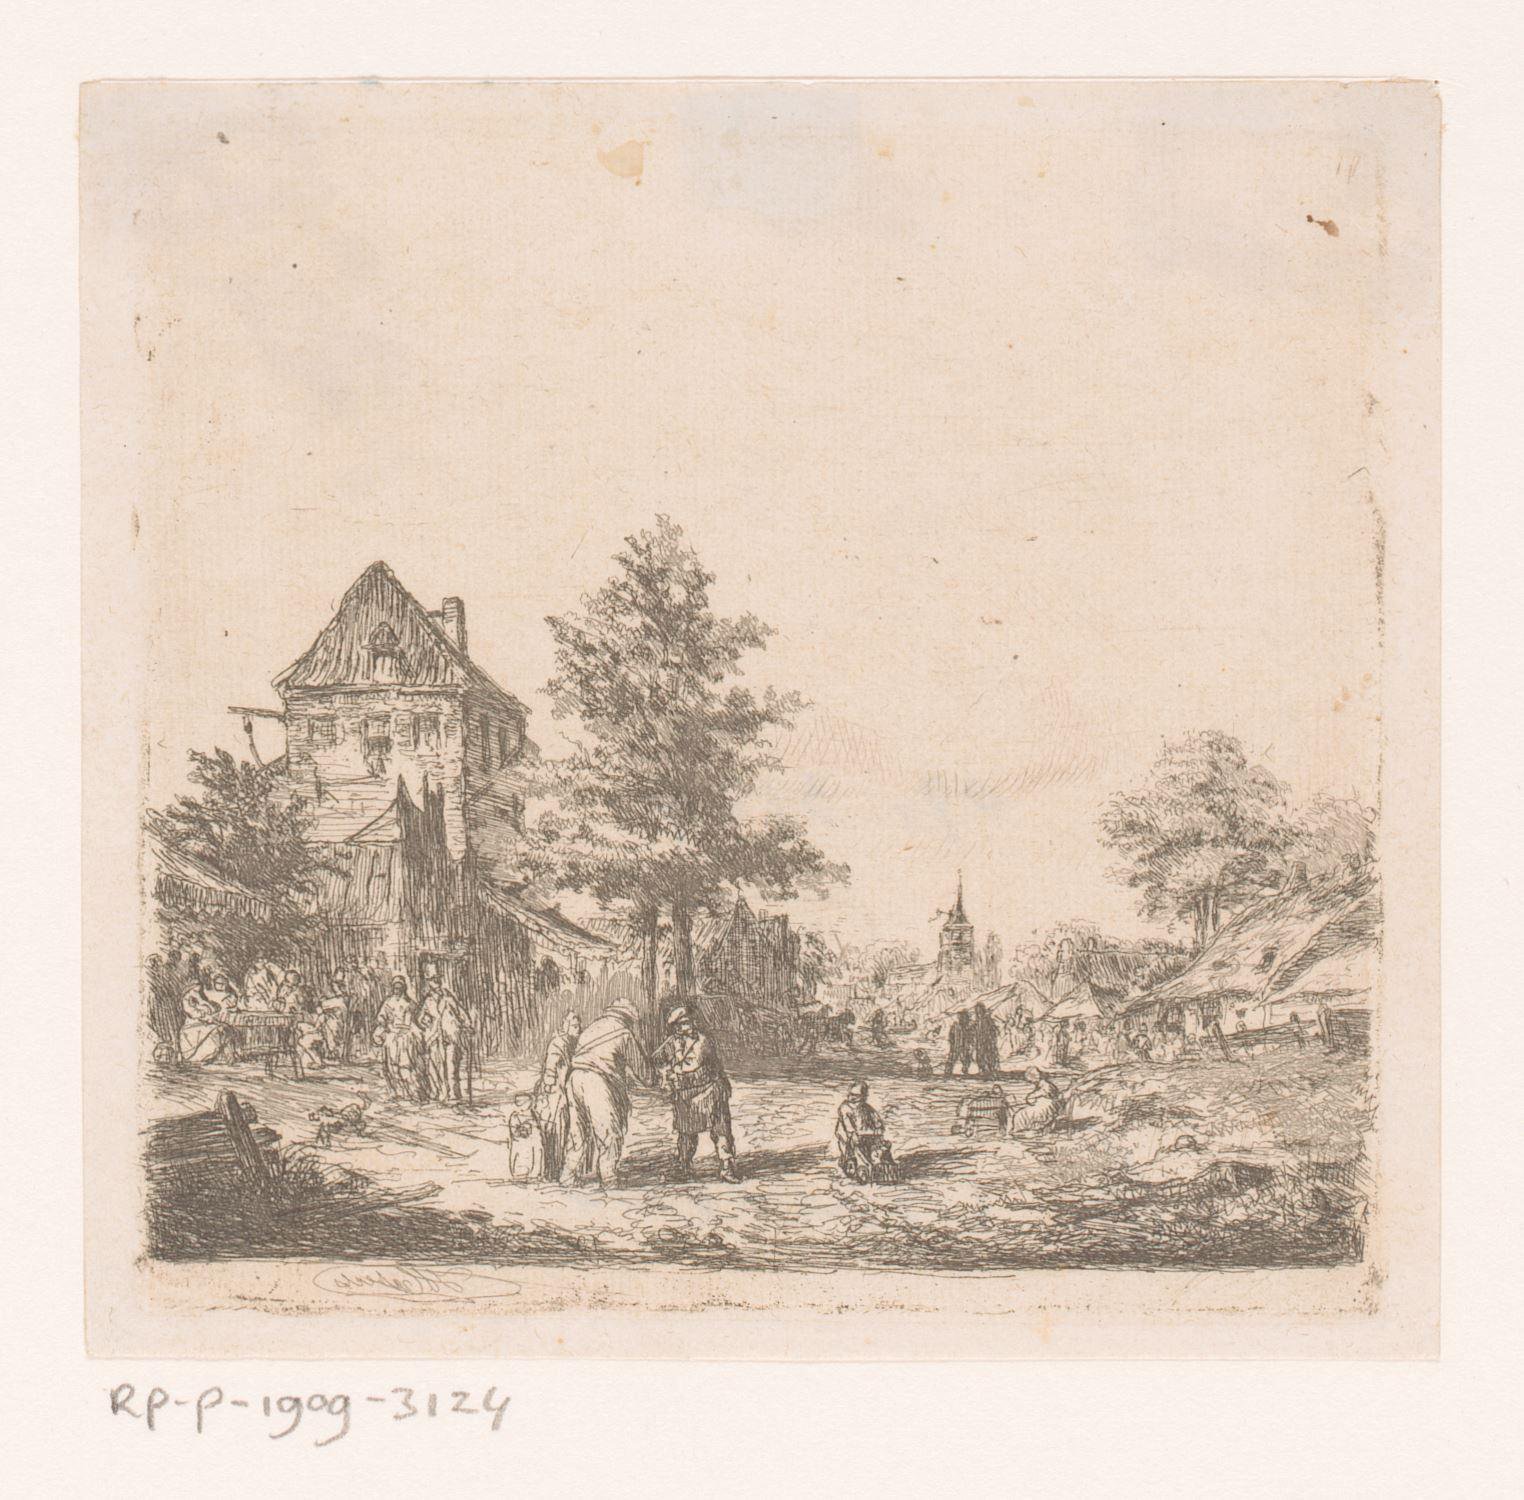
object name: print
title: Dorpsgezicht met veel mensen op straat en een kerk op de achtergrond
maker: florent nicolas crabeels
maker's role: print maker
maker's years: 1829-1896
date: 1849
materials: paper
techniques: etching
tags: village, public festivities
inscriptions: collector's mark: Lugt 2228, collector's mark: Lugt 1485